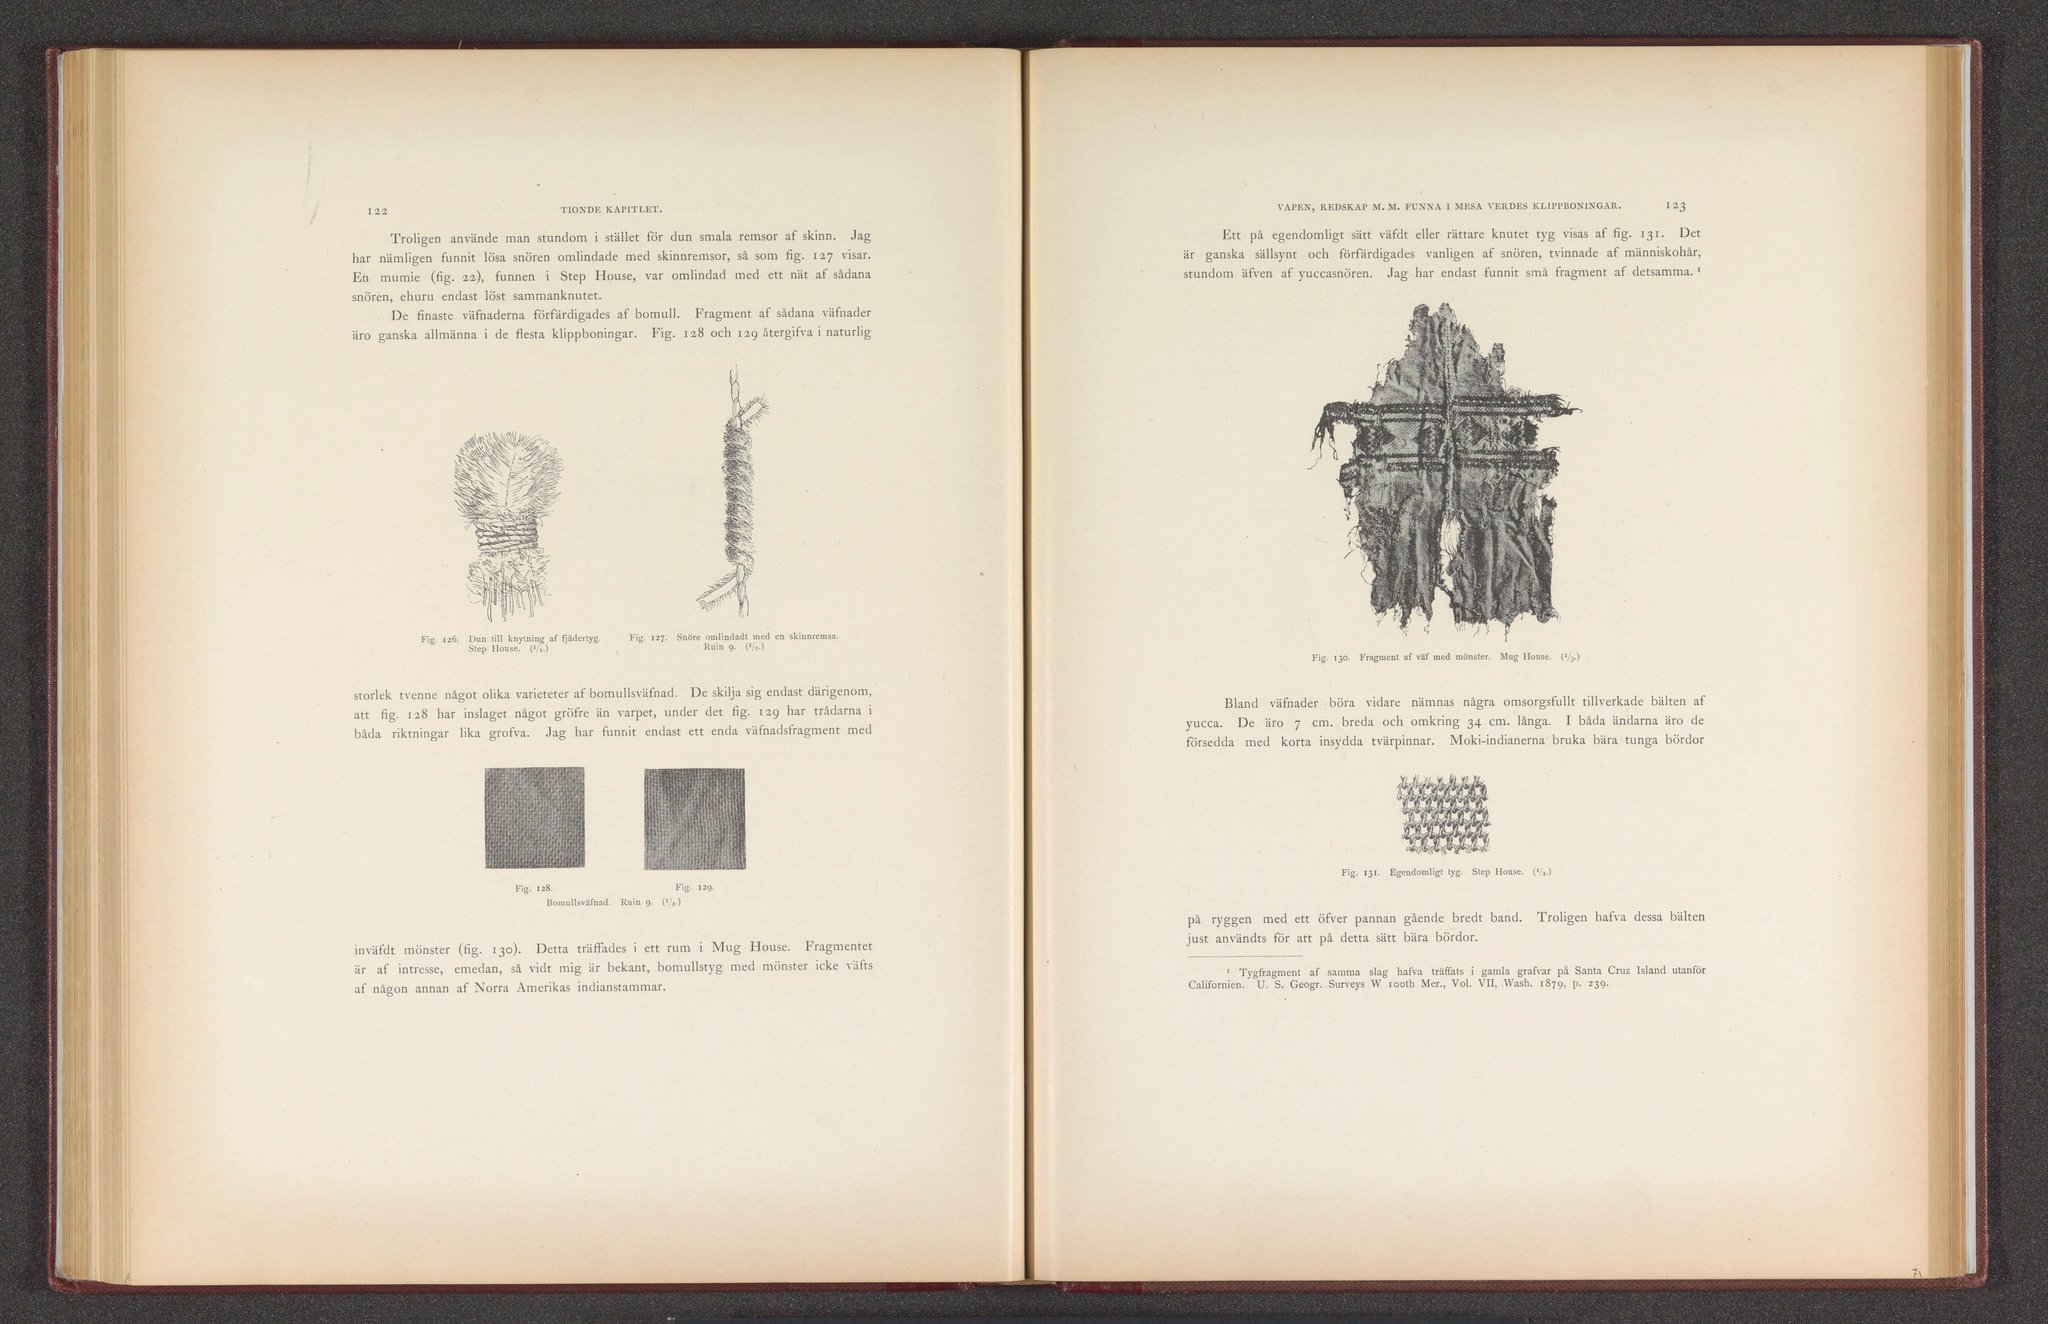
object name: photomechanical print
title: Bomullsväfnad. Ruin 9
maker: gustaf nordenskiöld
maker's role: fotograaf, schrijver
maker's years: 1868-1895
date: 1891-1893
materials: paper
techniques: autotype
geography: mesa verde national park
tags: cotton (material ~ textile industry)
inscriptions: number: ‘Fig. 128. Fig. 129.’